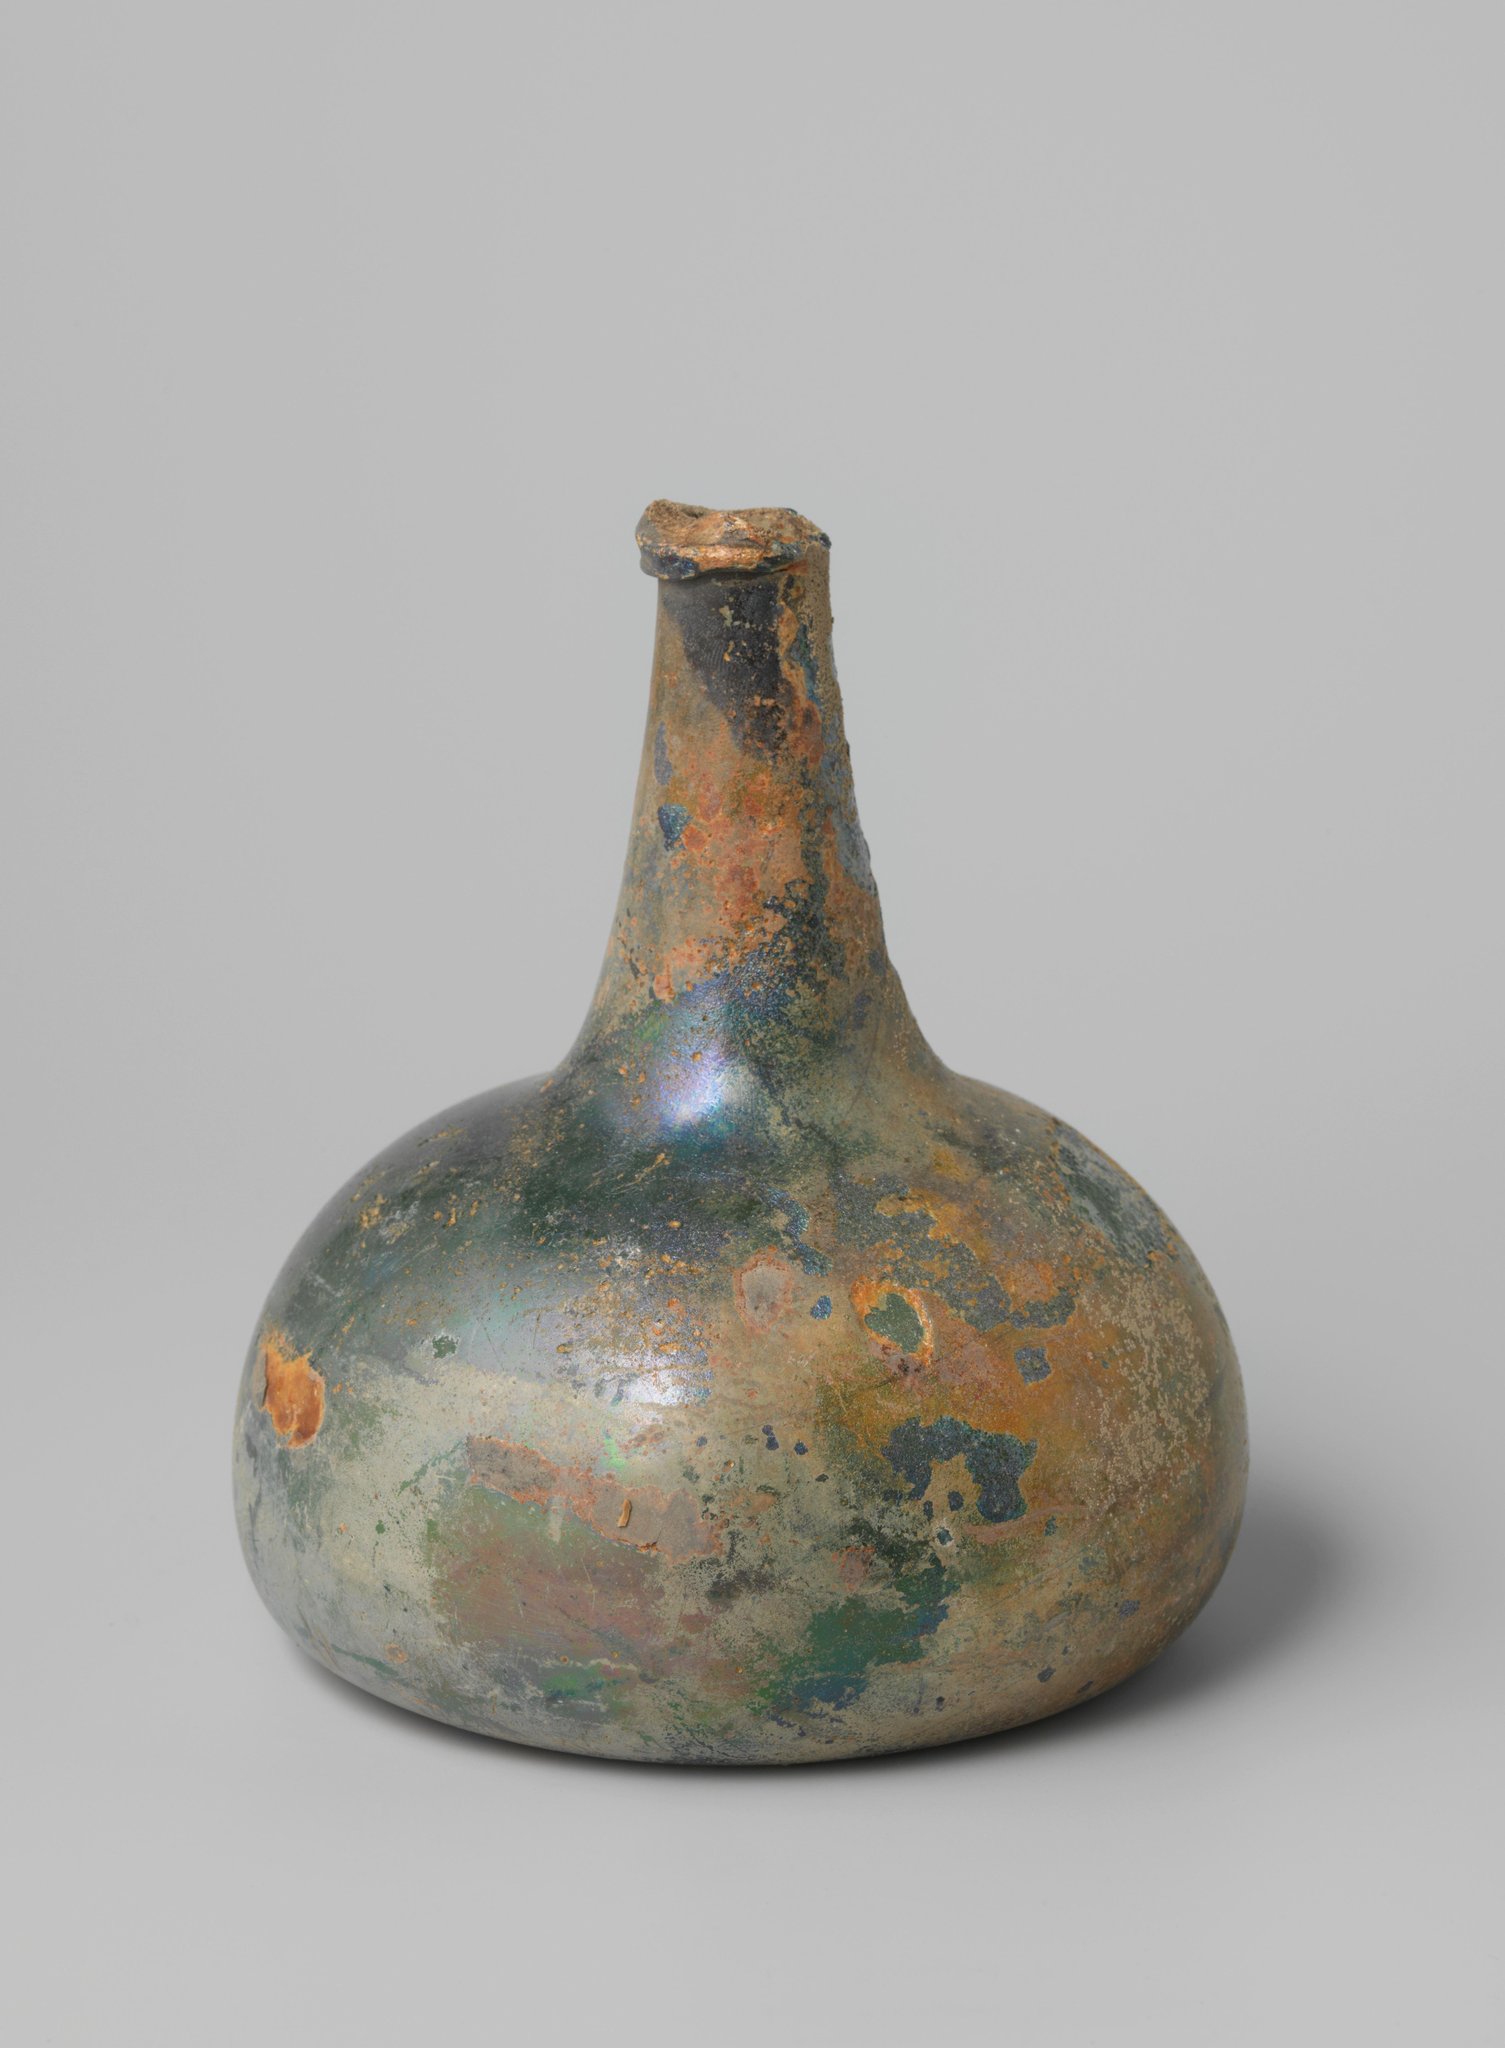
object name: wine bottle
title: Wijnfles uit het wrak van de Oostindiëvaarder 't Vliegend Hart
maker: Anonymous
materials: glass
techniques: green glass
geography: netherlands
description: Uivormige wijnfles van glas. Fragment van de mond ontbreekt en er zit een gat in.